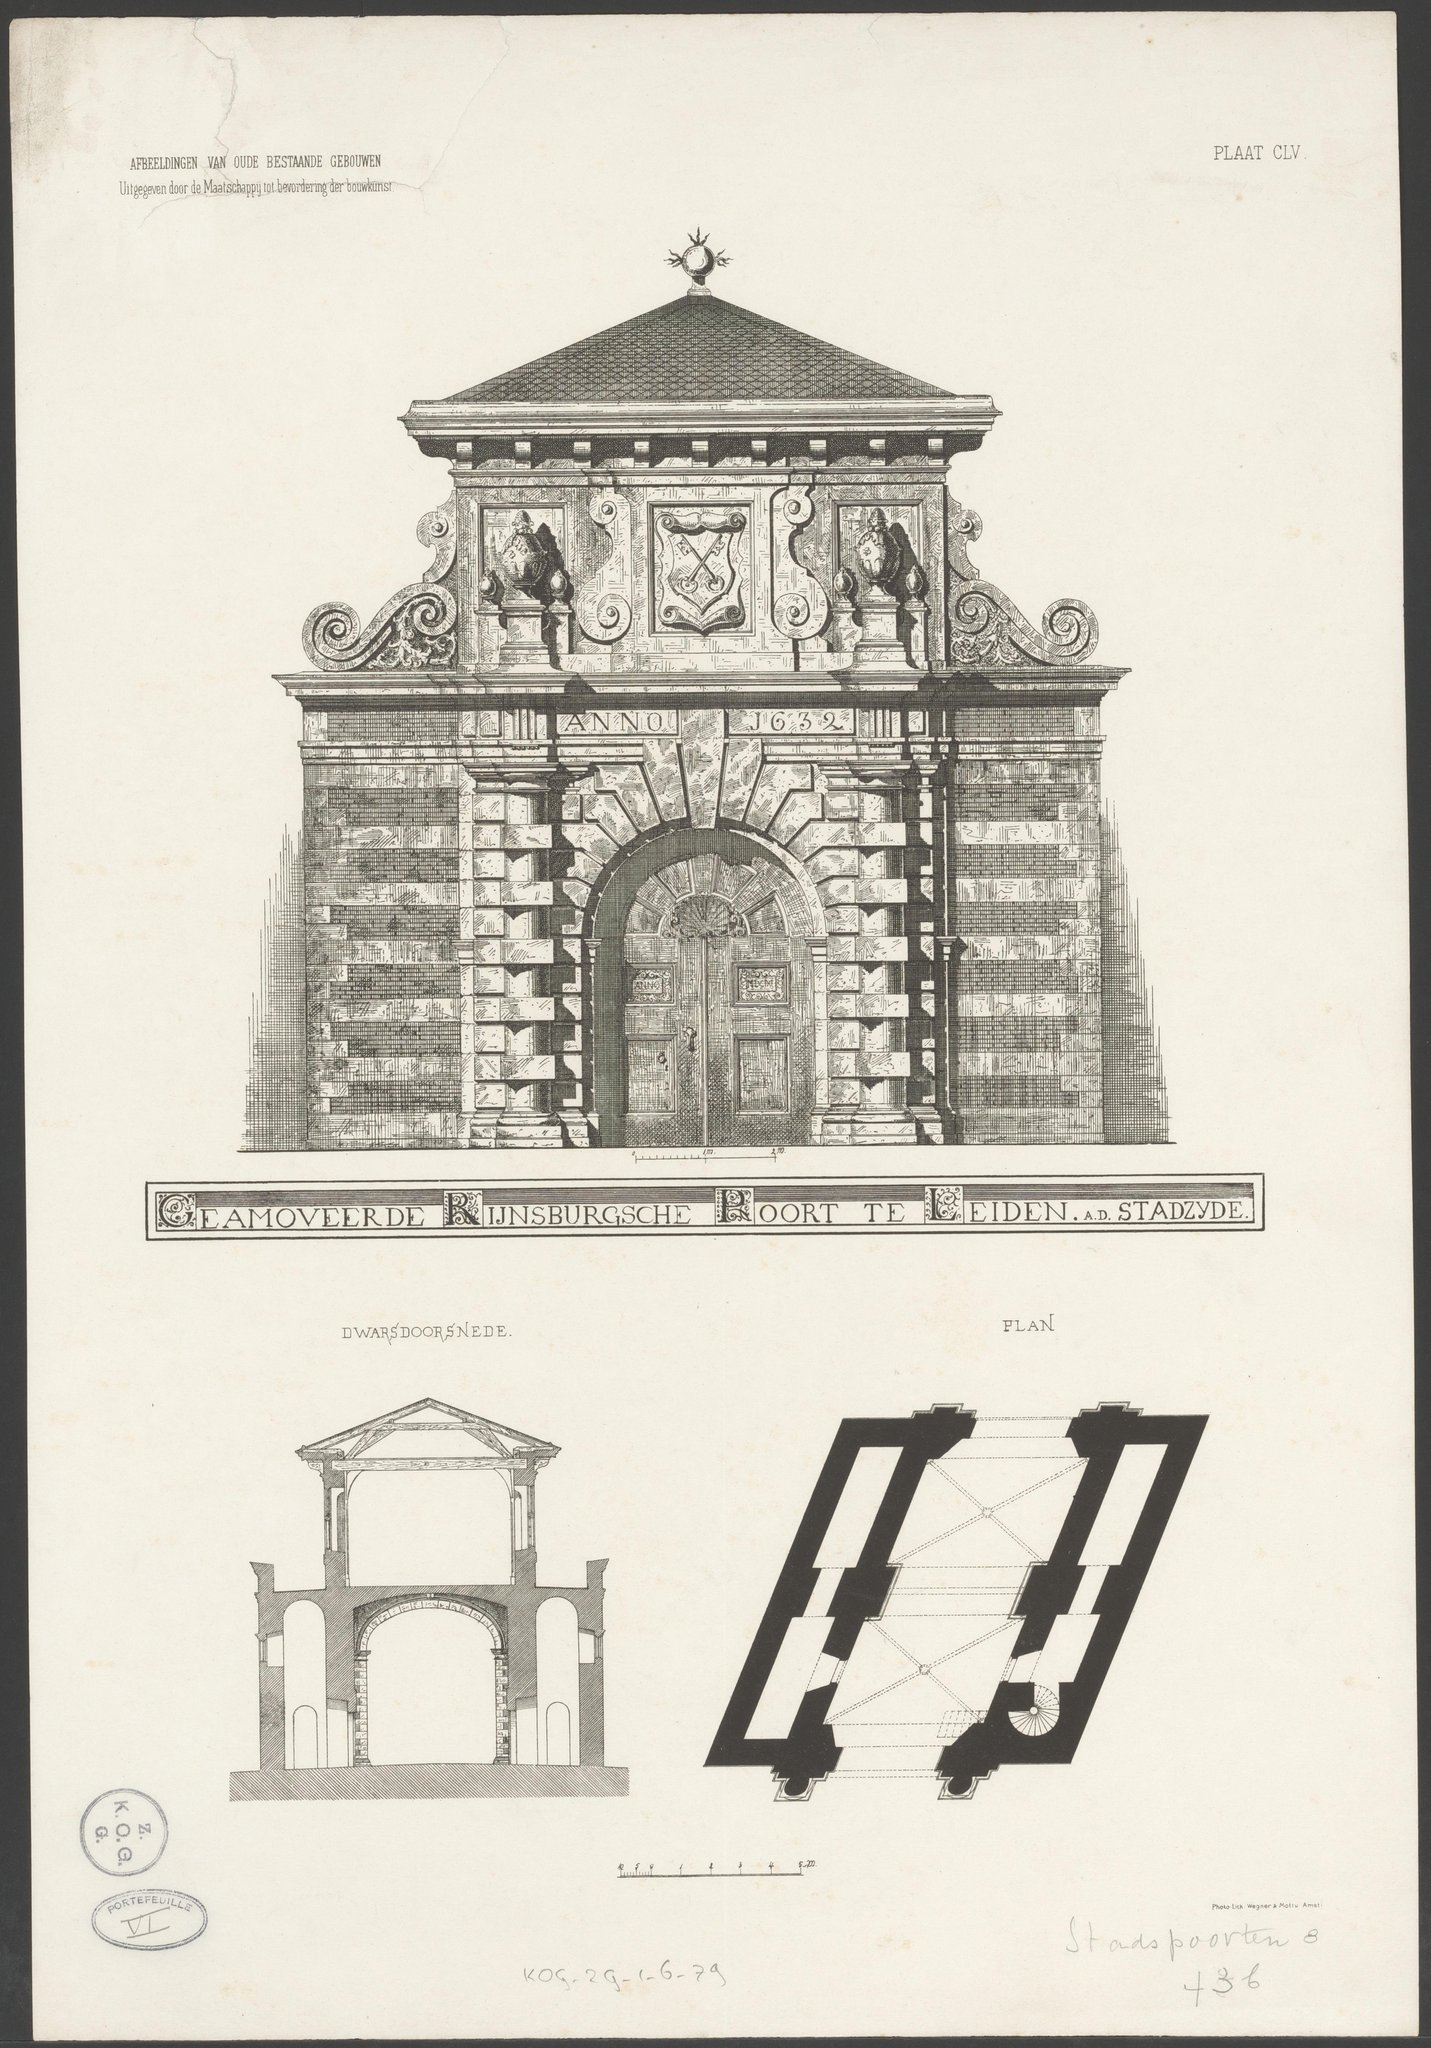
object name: photomechanical print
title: Geamoveerde Rijnburgsche Poort te Leiden, aan de buitenzyde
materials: paper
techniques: photolithography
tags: plan ~ architecture, city-gate, leiden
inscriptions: collector's mark: Lugt 1641, stamp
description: Rijnsburgerpoort te Leiden. Onderaan een dwarsdoorsnede en een plattegrond. Rechtsboven genummerd: Plaat CLV. Onderwerpsrubrieken binnen de Atlas Zeden en Gewoonten: Krijgswezen, Stadspoorten.